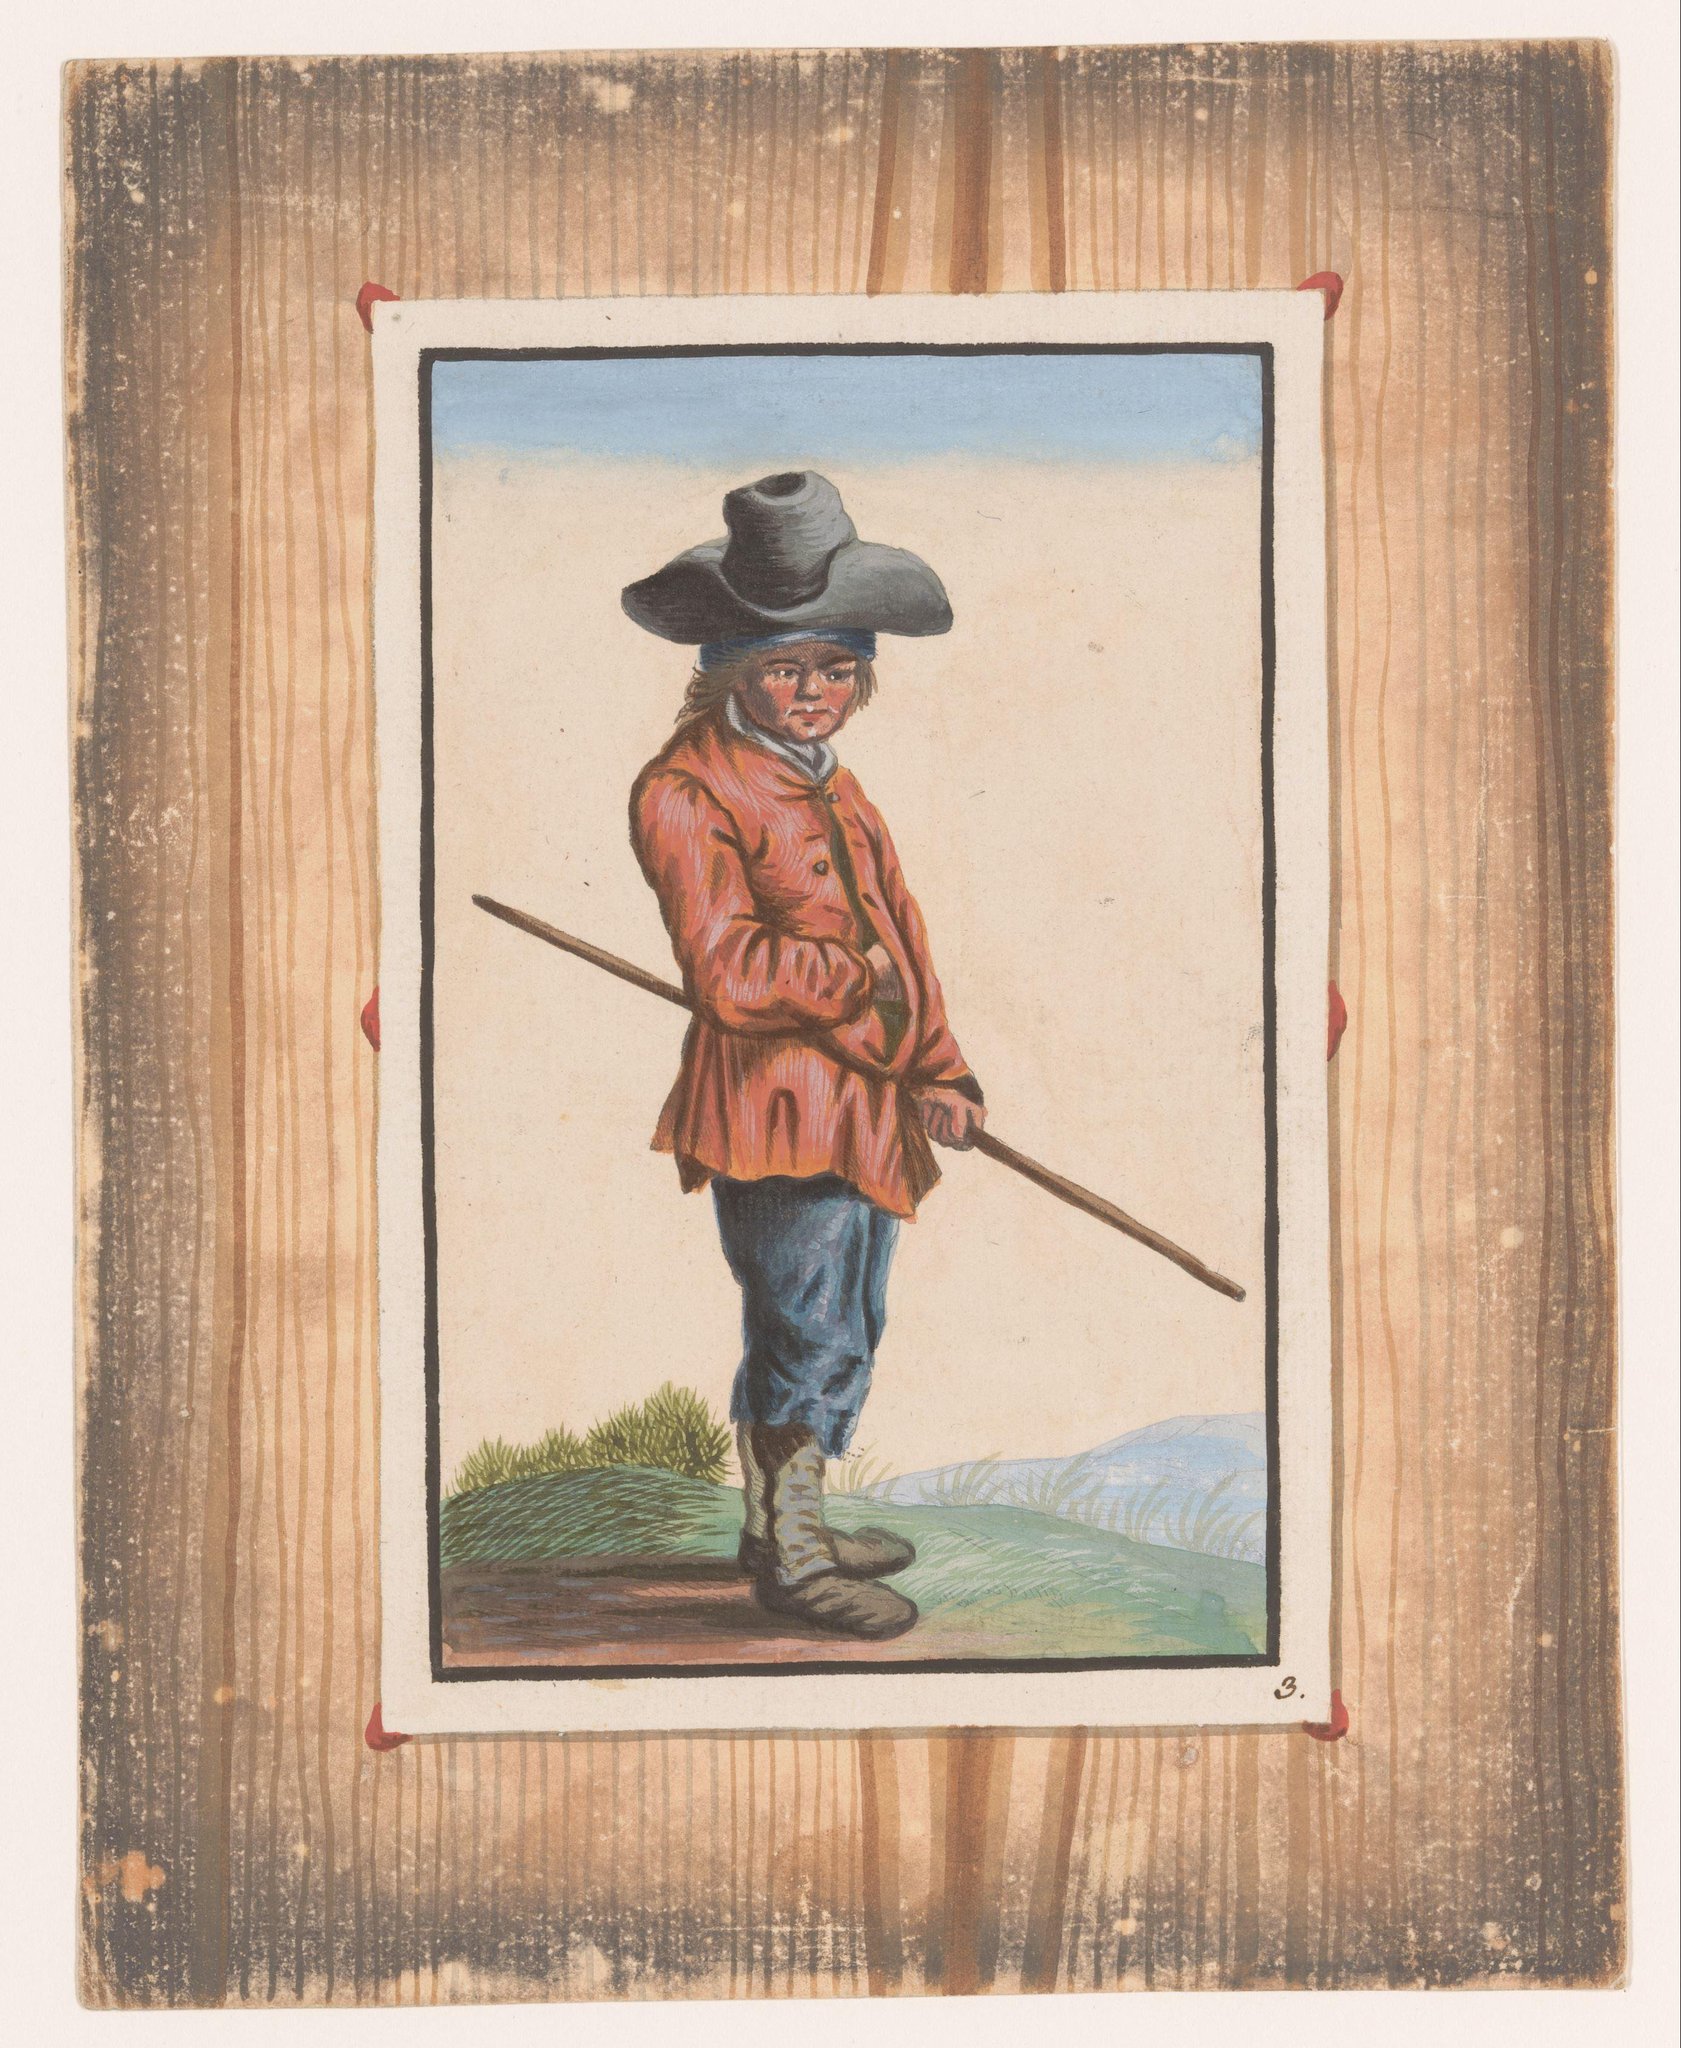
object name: print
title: Staande jongen met stok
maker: Anonymous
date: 1740-1760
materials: paper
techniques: etching, hand coloring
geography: germany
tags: 'trompe l'oeil'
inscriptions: collector's mark: Lugt 2228, collector's mark: Lugt 2228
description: Trompe l'oeil: alsof het blad met de voorstelling tegen een houten wand is bevestigd.